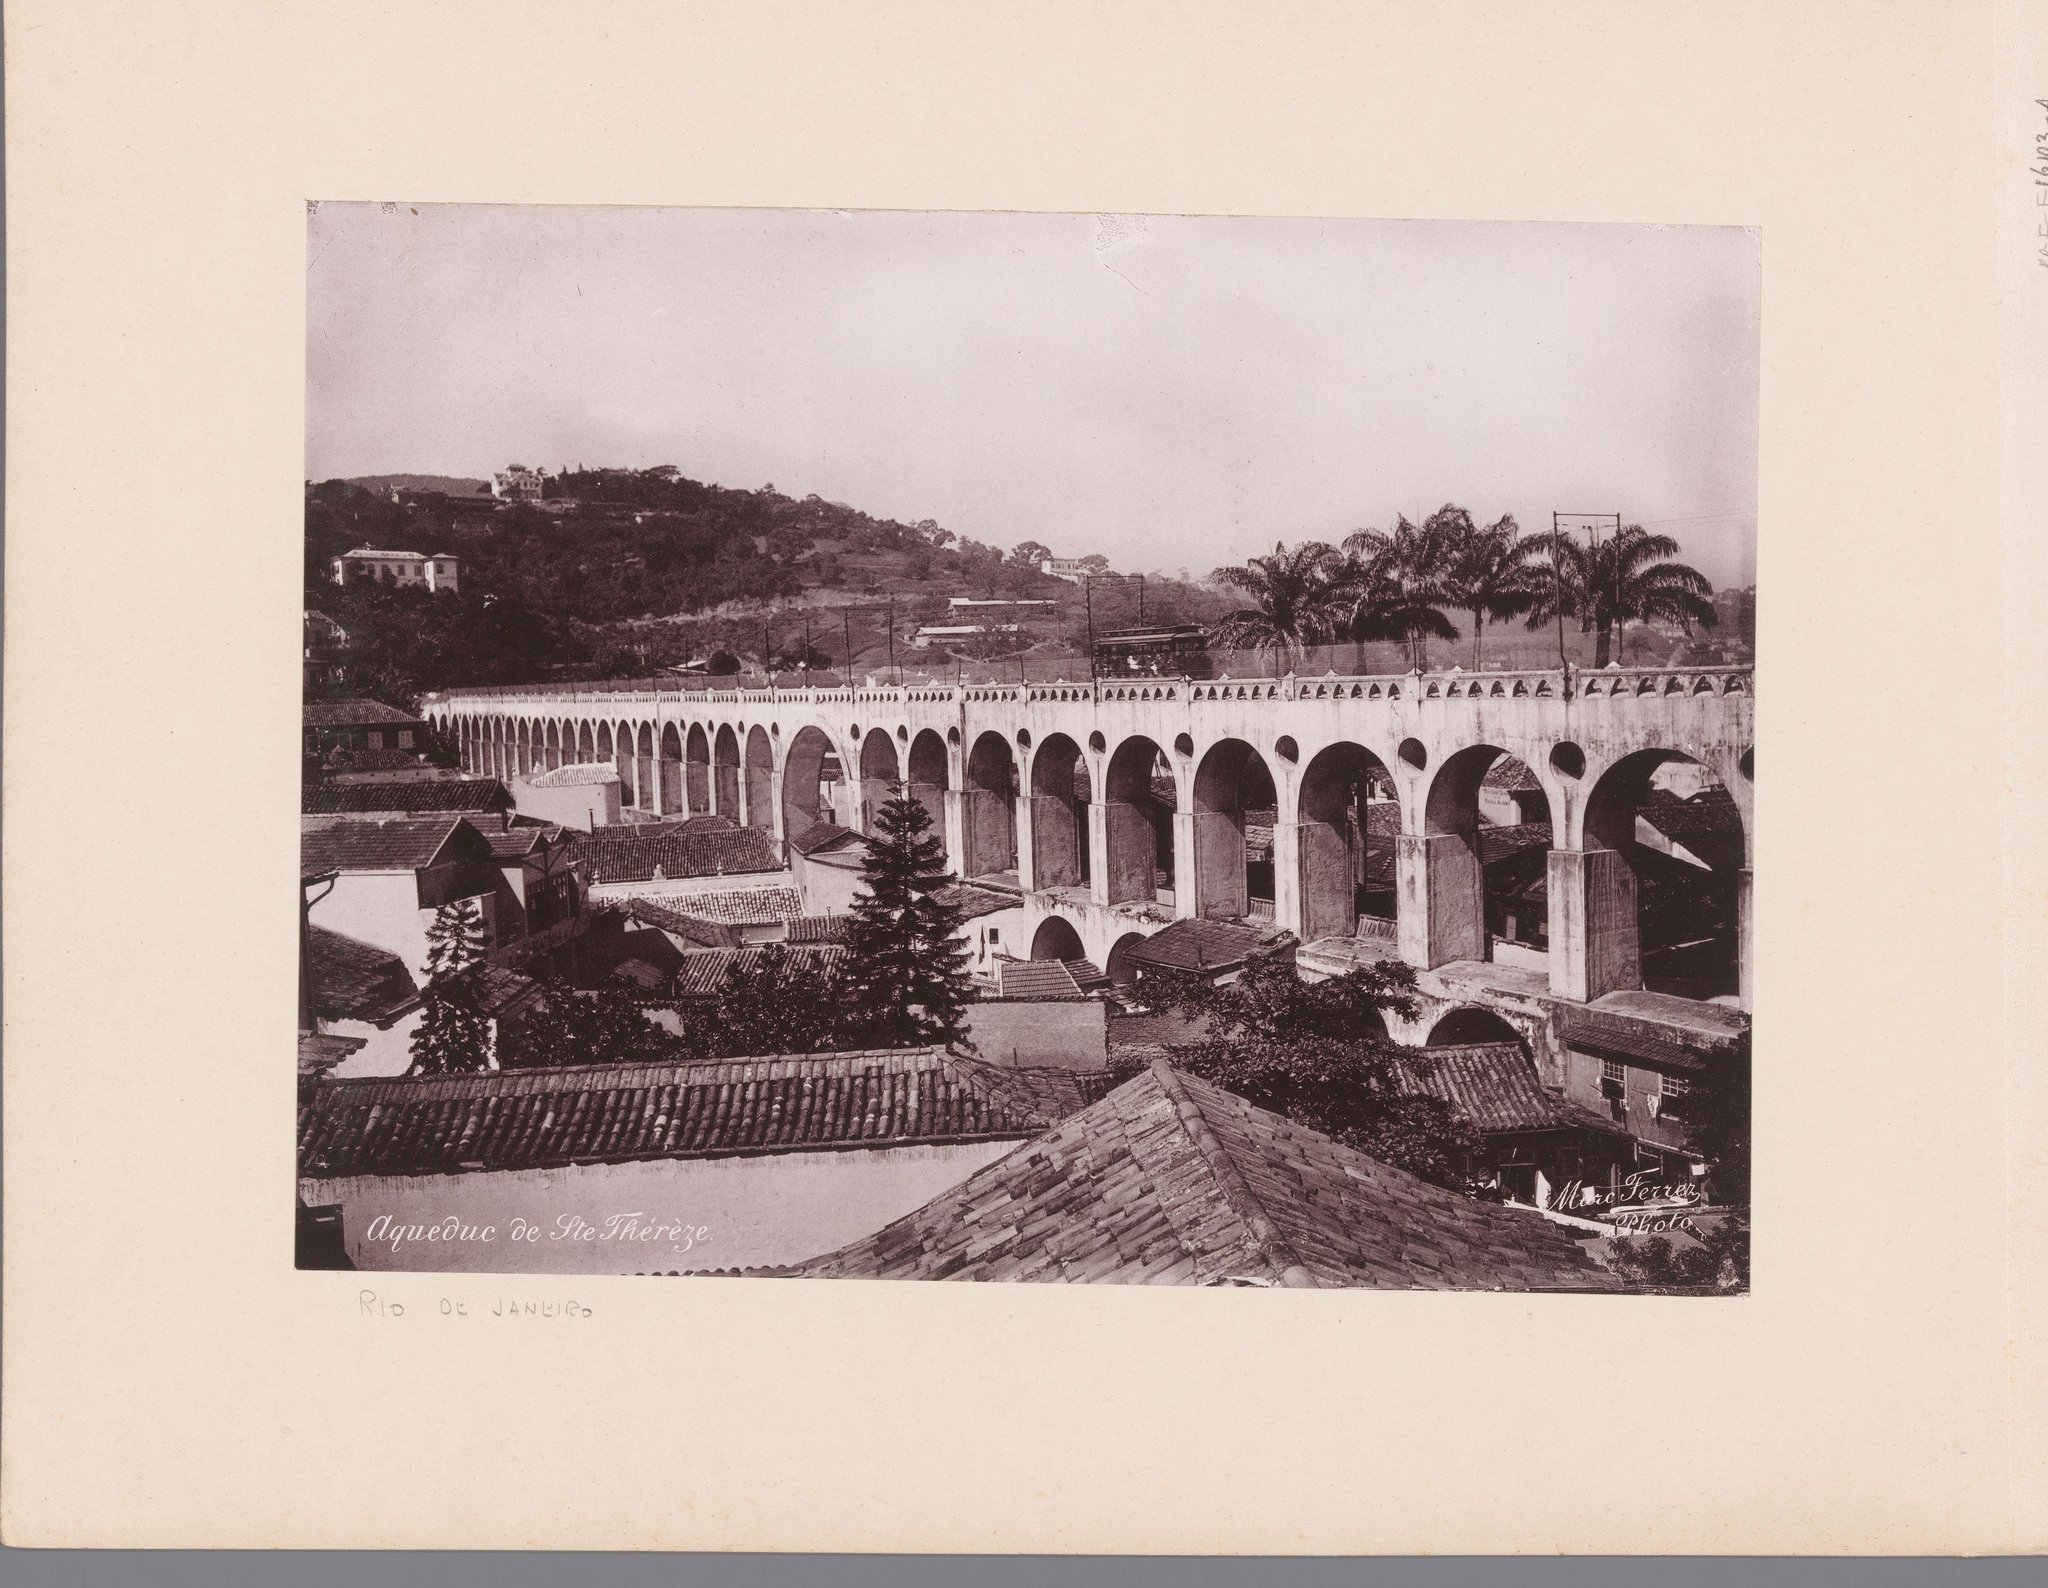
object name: photomechanical print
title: Sainte Thérèze aquaduct in Rio de Janeiro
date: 1890-1910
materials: cardboard, paper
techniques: photograph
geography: rio de janeiro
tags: landscape with bridge, viaduct or aqueduct